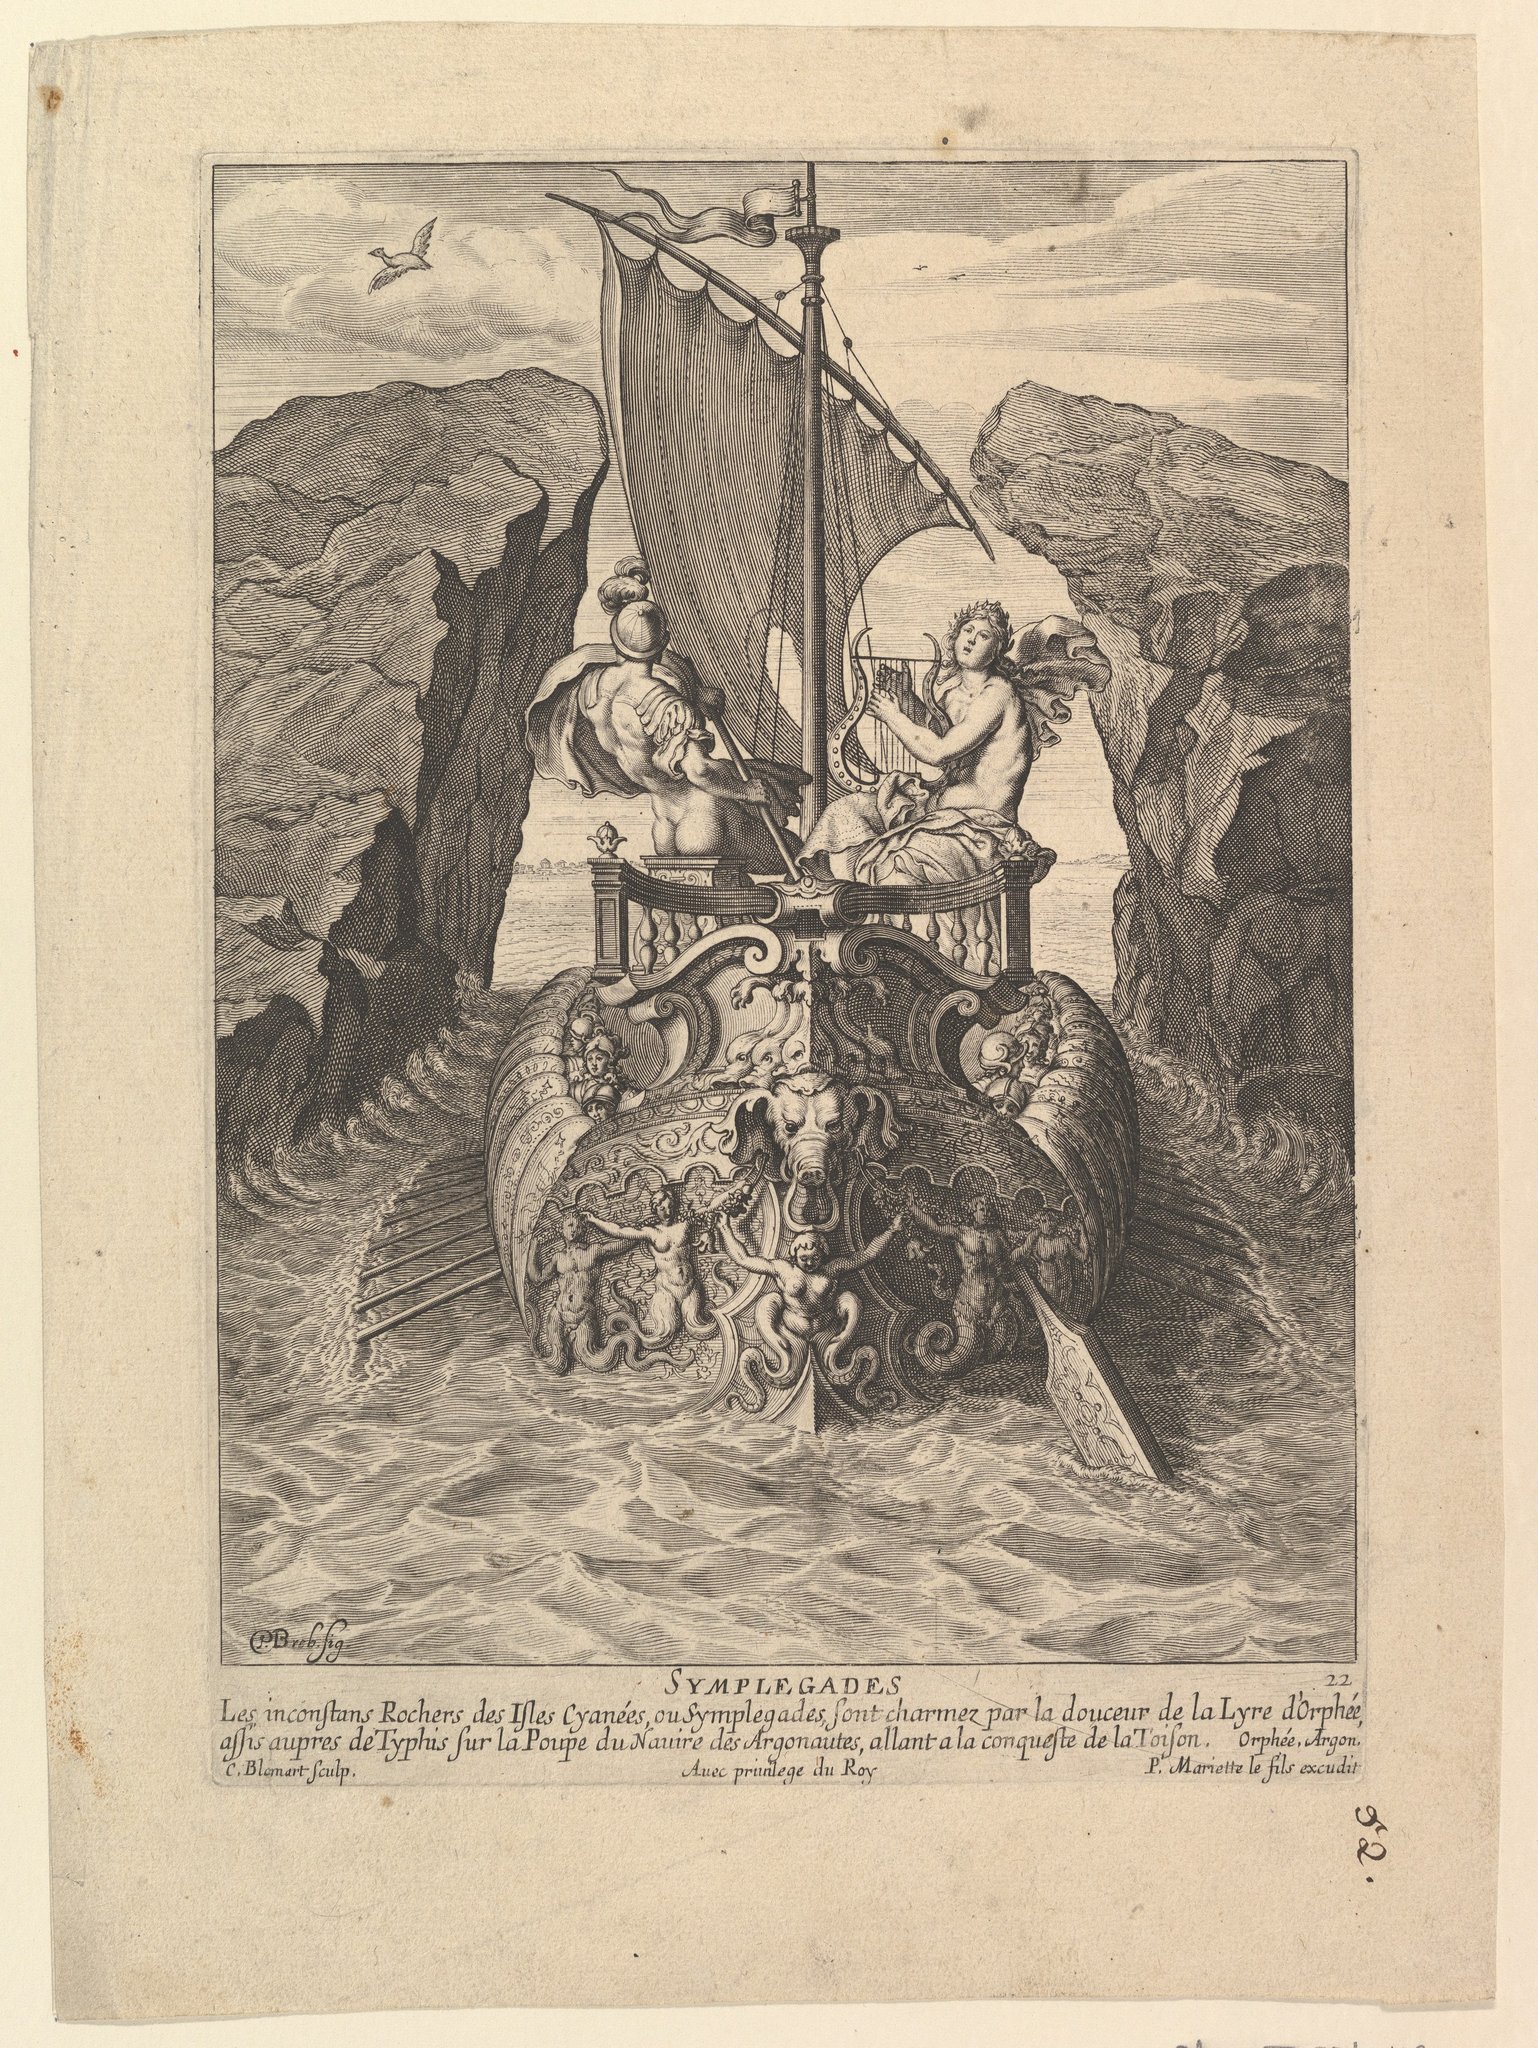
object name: print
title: Symplegades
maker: cornelis bloemaert (ii)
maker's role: artist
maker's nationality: dutch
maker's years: 1603-1684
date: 1601-1700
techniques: engraving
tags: musical instruments,men,musicians,ships